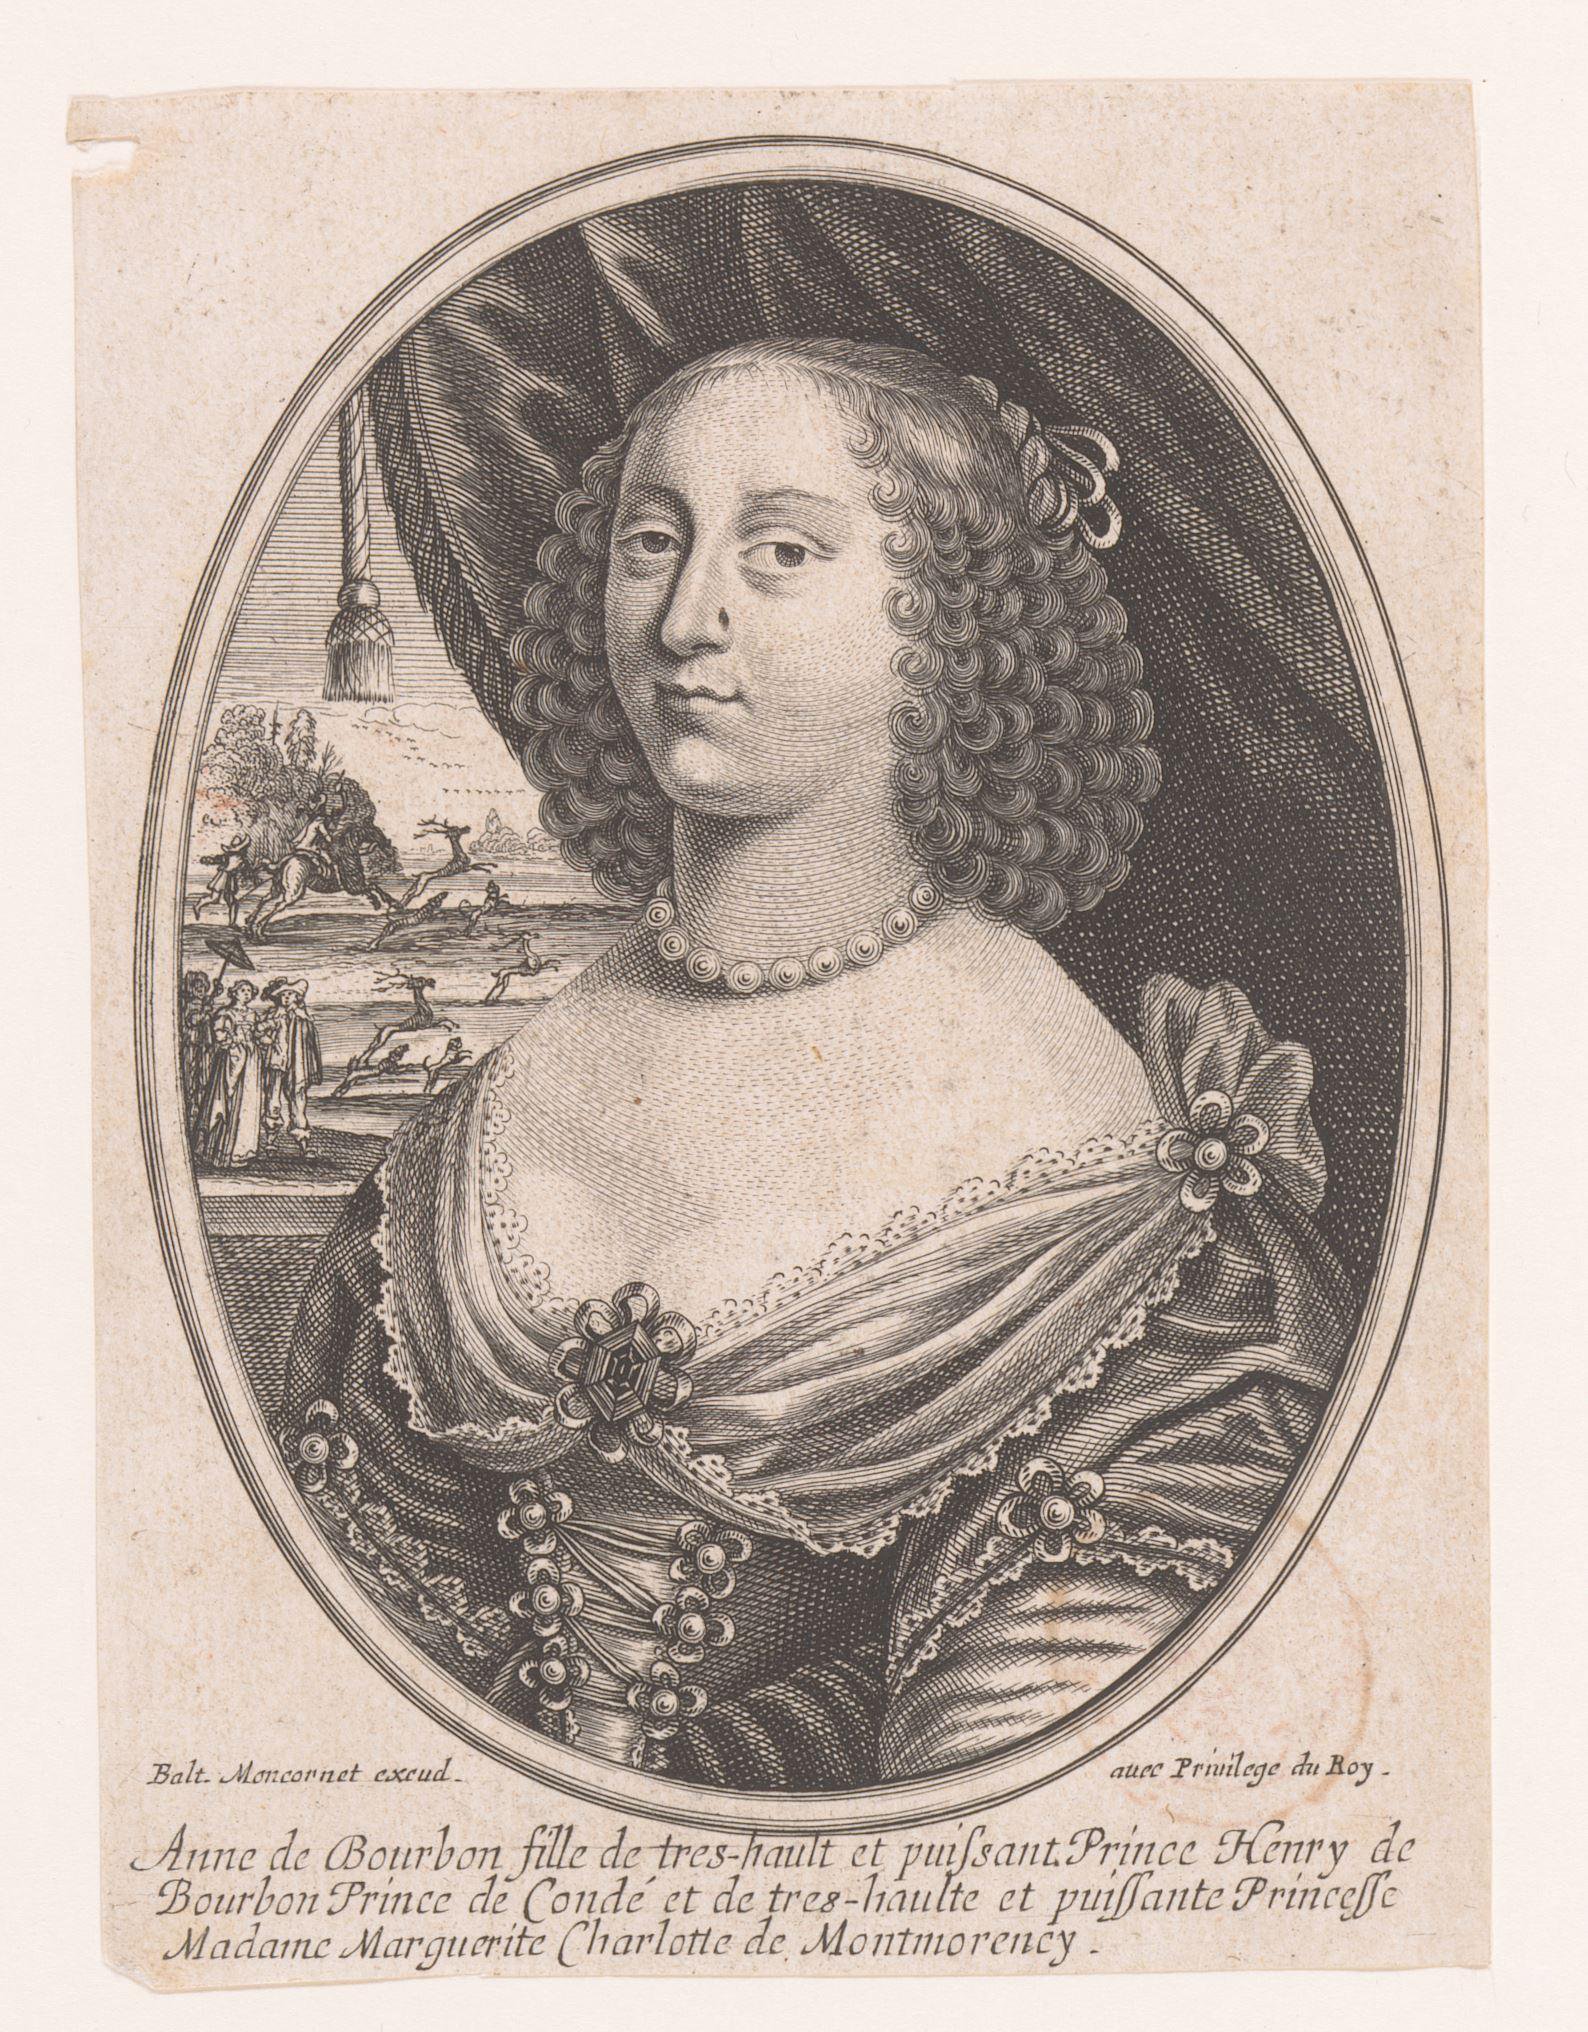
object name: print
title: Portret van Anna Genoveva van Bourbon-Condé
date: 1634-1668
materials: paper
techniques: engraving, etching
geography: france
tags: anna genoveva van bourbon-condé, historical persons - bb - woman, princess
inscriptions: collector's mark: Lugt 240